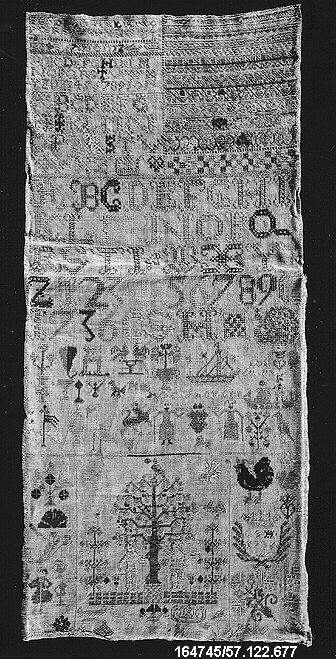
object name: sampler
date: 1736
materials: linen, silk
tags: human figures,chickens